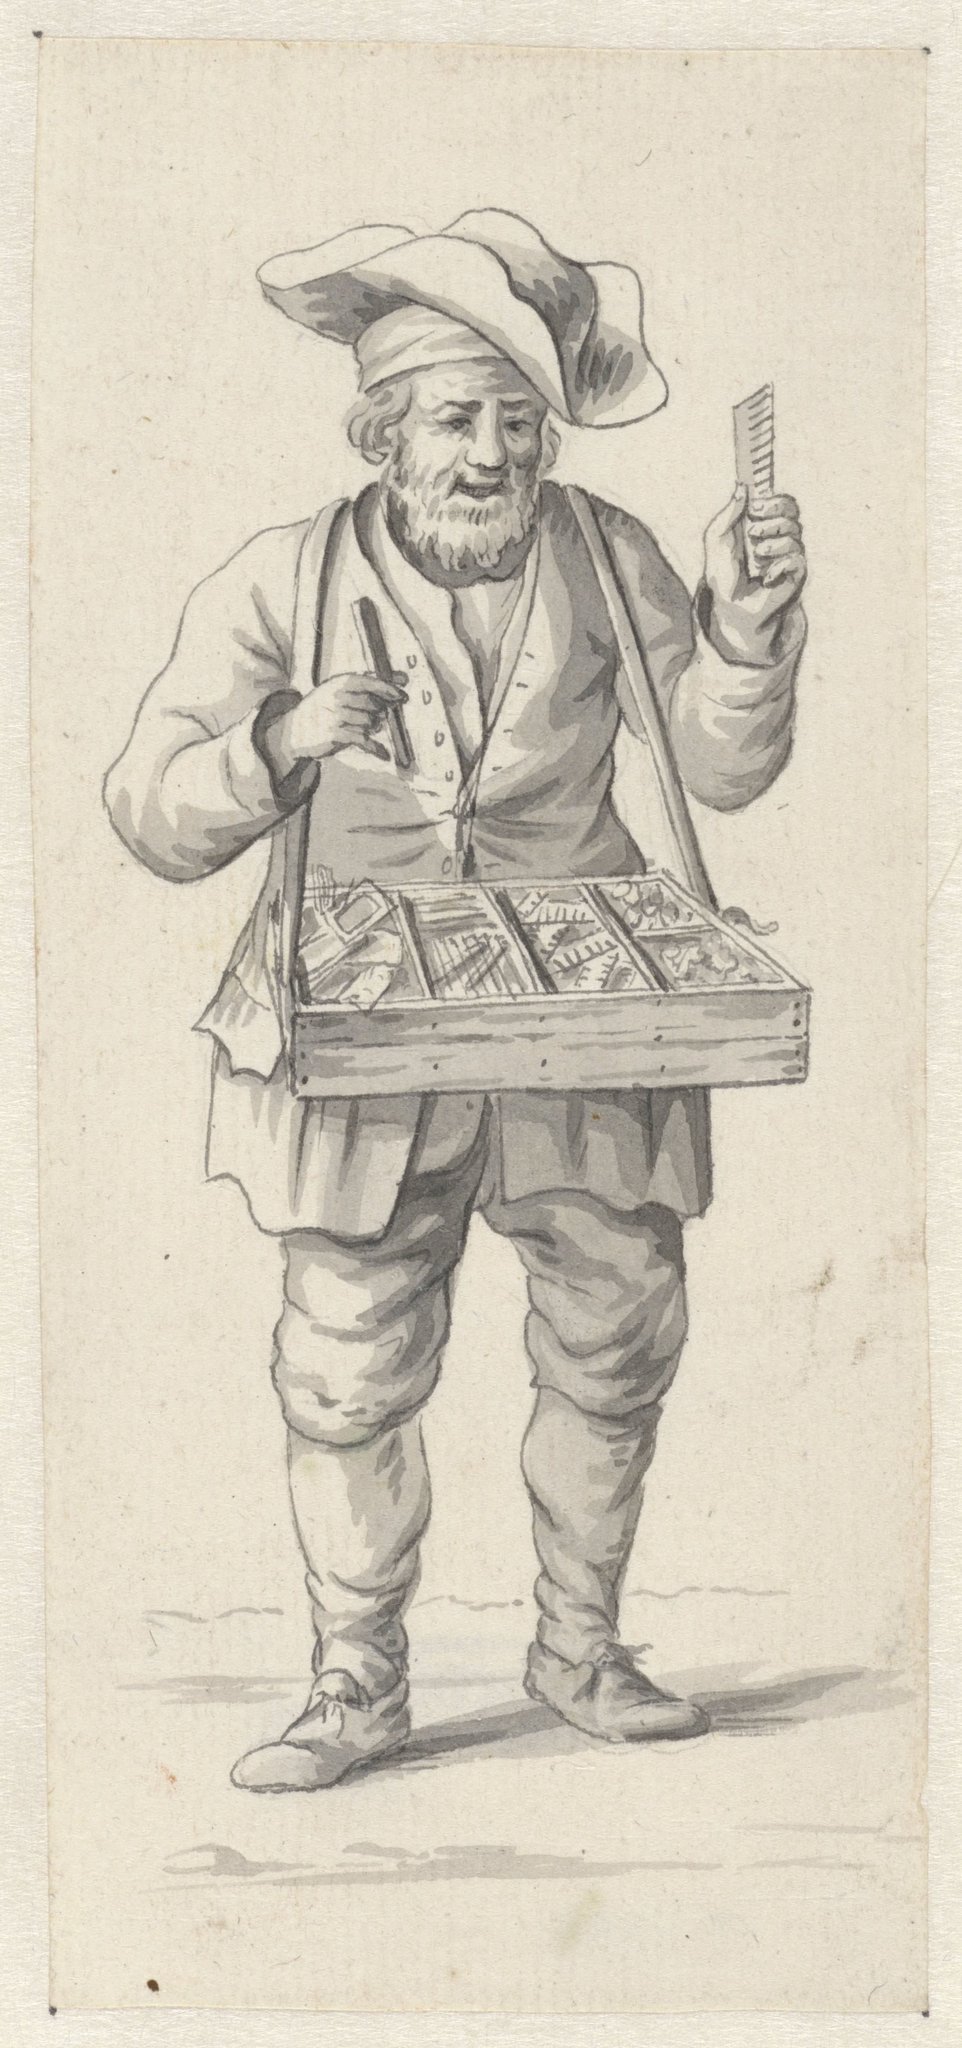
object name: drawing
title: Straatverkoper met kammen en naalden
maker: pieter de goeje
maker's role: draughtsman, print maker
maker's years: 1789-1859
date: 1789-1859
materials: ink, paper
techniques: brush, pen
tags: street-trader